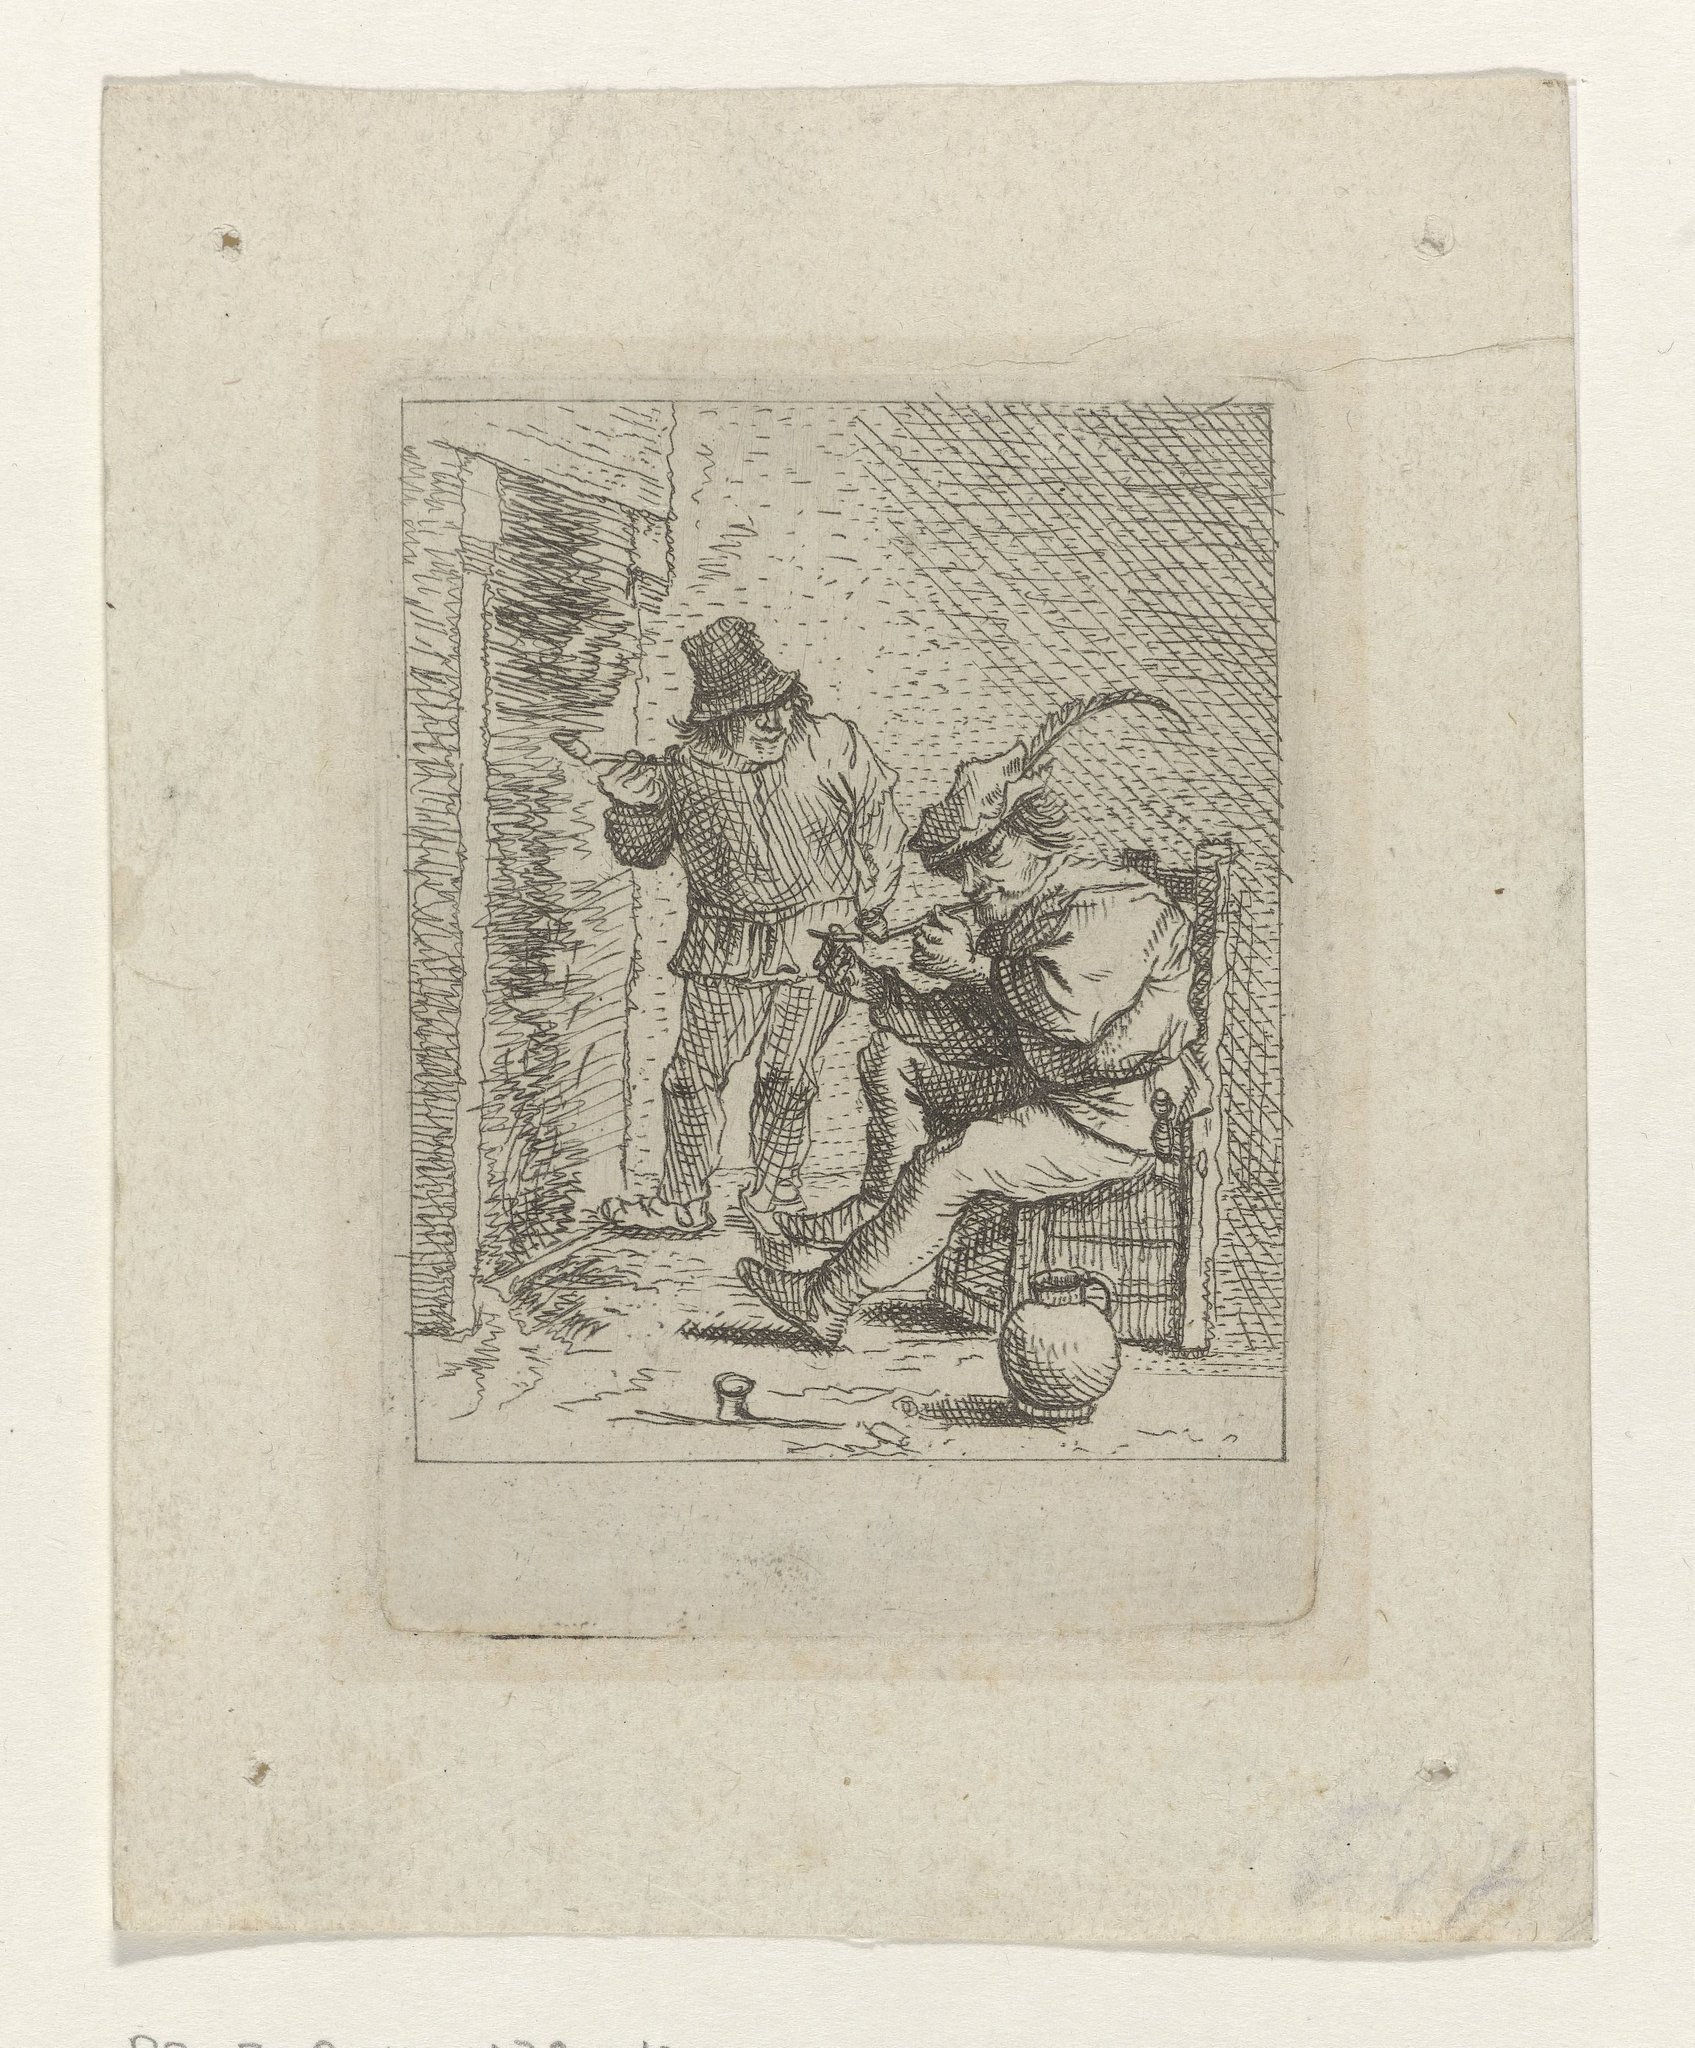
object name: print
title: Twee rokende boeren bij een haard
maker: Anonymous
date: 1600-1750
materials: paper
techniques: etching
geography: europe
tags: pipe ~ tobacco, farmers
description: Na de overname van de firma Niemeyer door British American Tabacco Group besloot deze de collectie van het Niemeyer Tabaksmuseum af te stoten. De beheerder van de collectie, het Noordelijk Scheepvaartmuseum, organiseerde in januari 2011 open dagen voor musea waar deze hun voorkeuren voor collectieonderdelen kenbaar konden maken. De objecten zijn getaxeerd door medewerkers van Christie's en vervolgens ter overname aangeboden aan de belangstellende musea. Het Rijksprentenkabinet koos 46 prenten uit de collectie tegen door de medewerkers van Christie's vastgestelde waarde. [H. Leeflang, 2011-06-09]